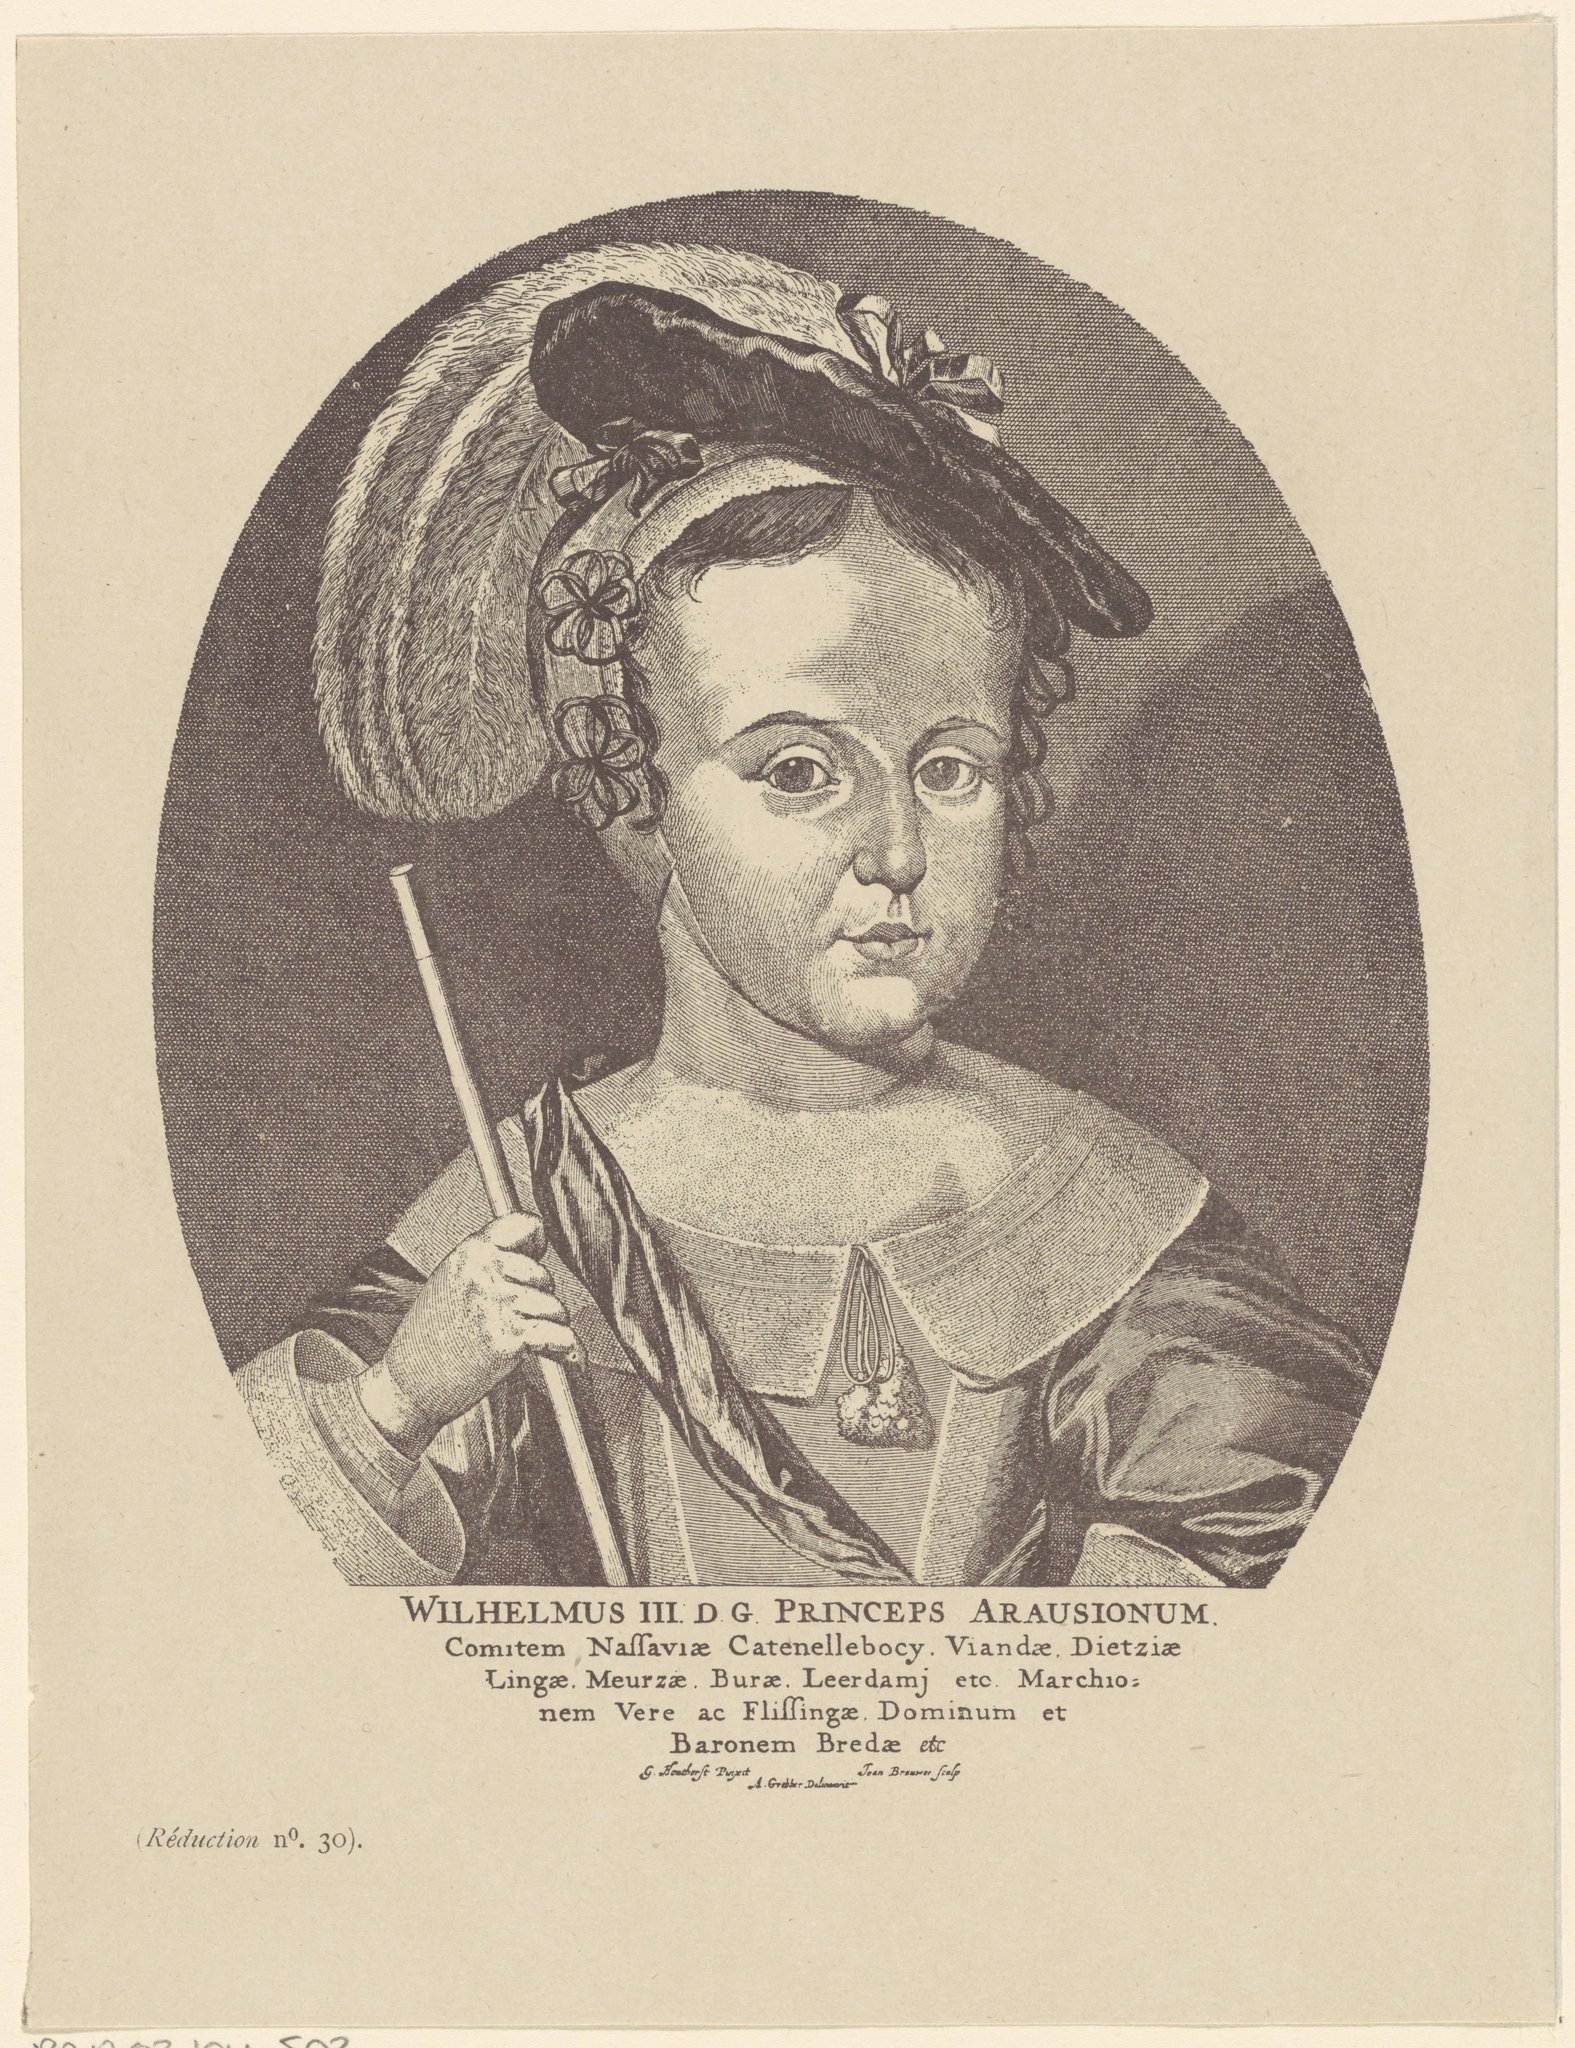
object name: print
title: Portret van Willem III, prins van Oranje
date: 1652-1688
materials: paper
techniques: engraving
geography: amsterdam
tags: the hague, william iii (prince of orange and king of england, scotland, and ireland)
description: De hier vermelde titel verwijst naar de hoogst verkregen titel van de geportretteerde, niet per se naar de titel die de geportretteerde op deze voorstelling draagt.